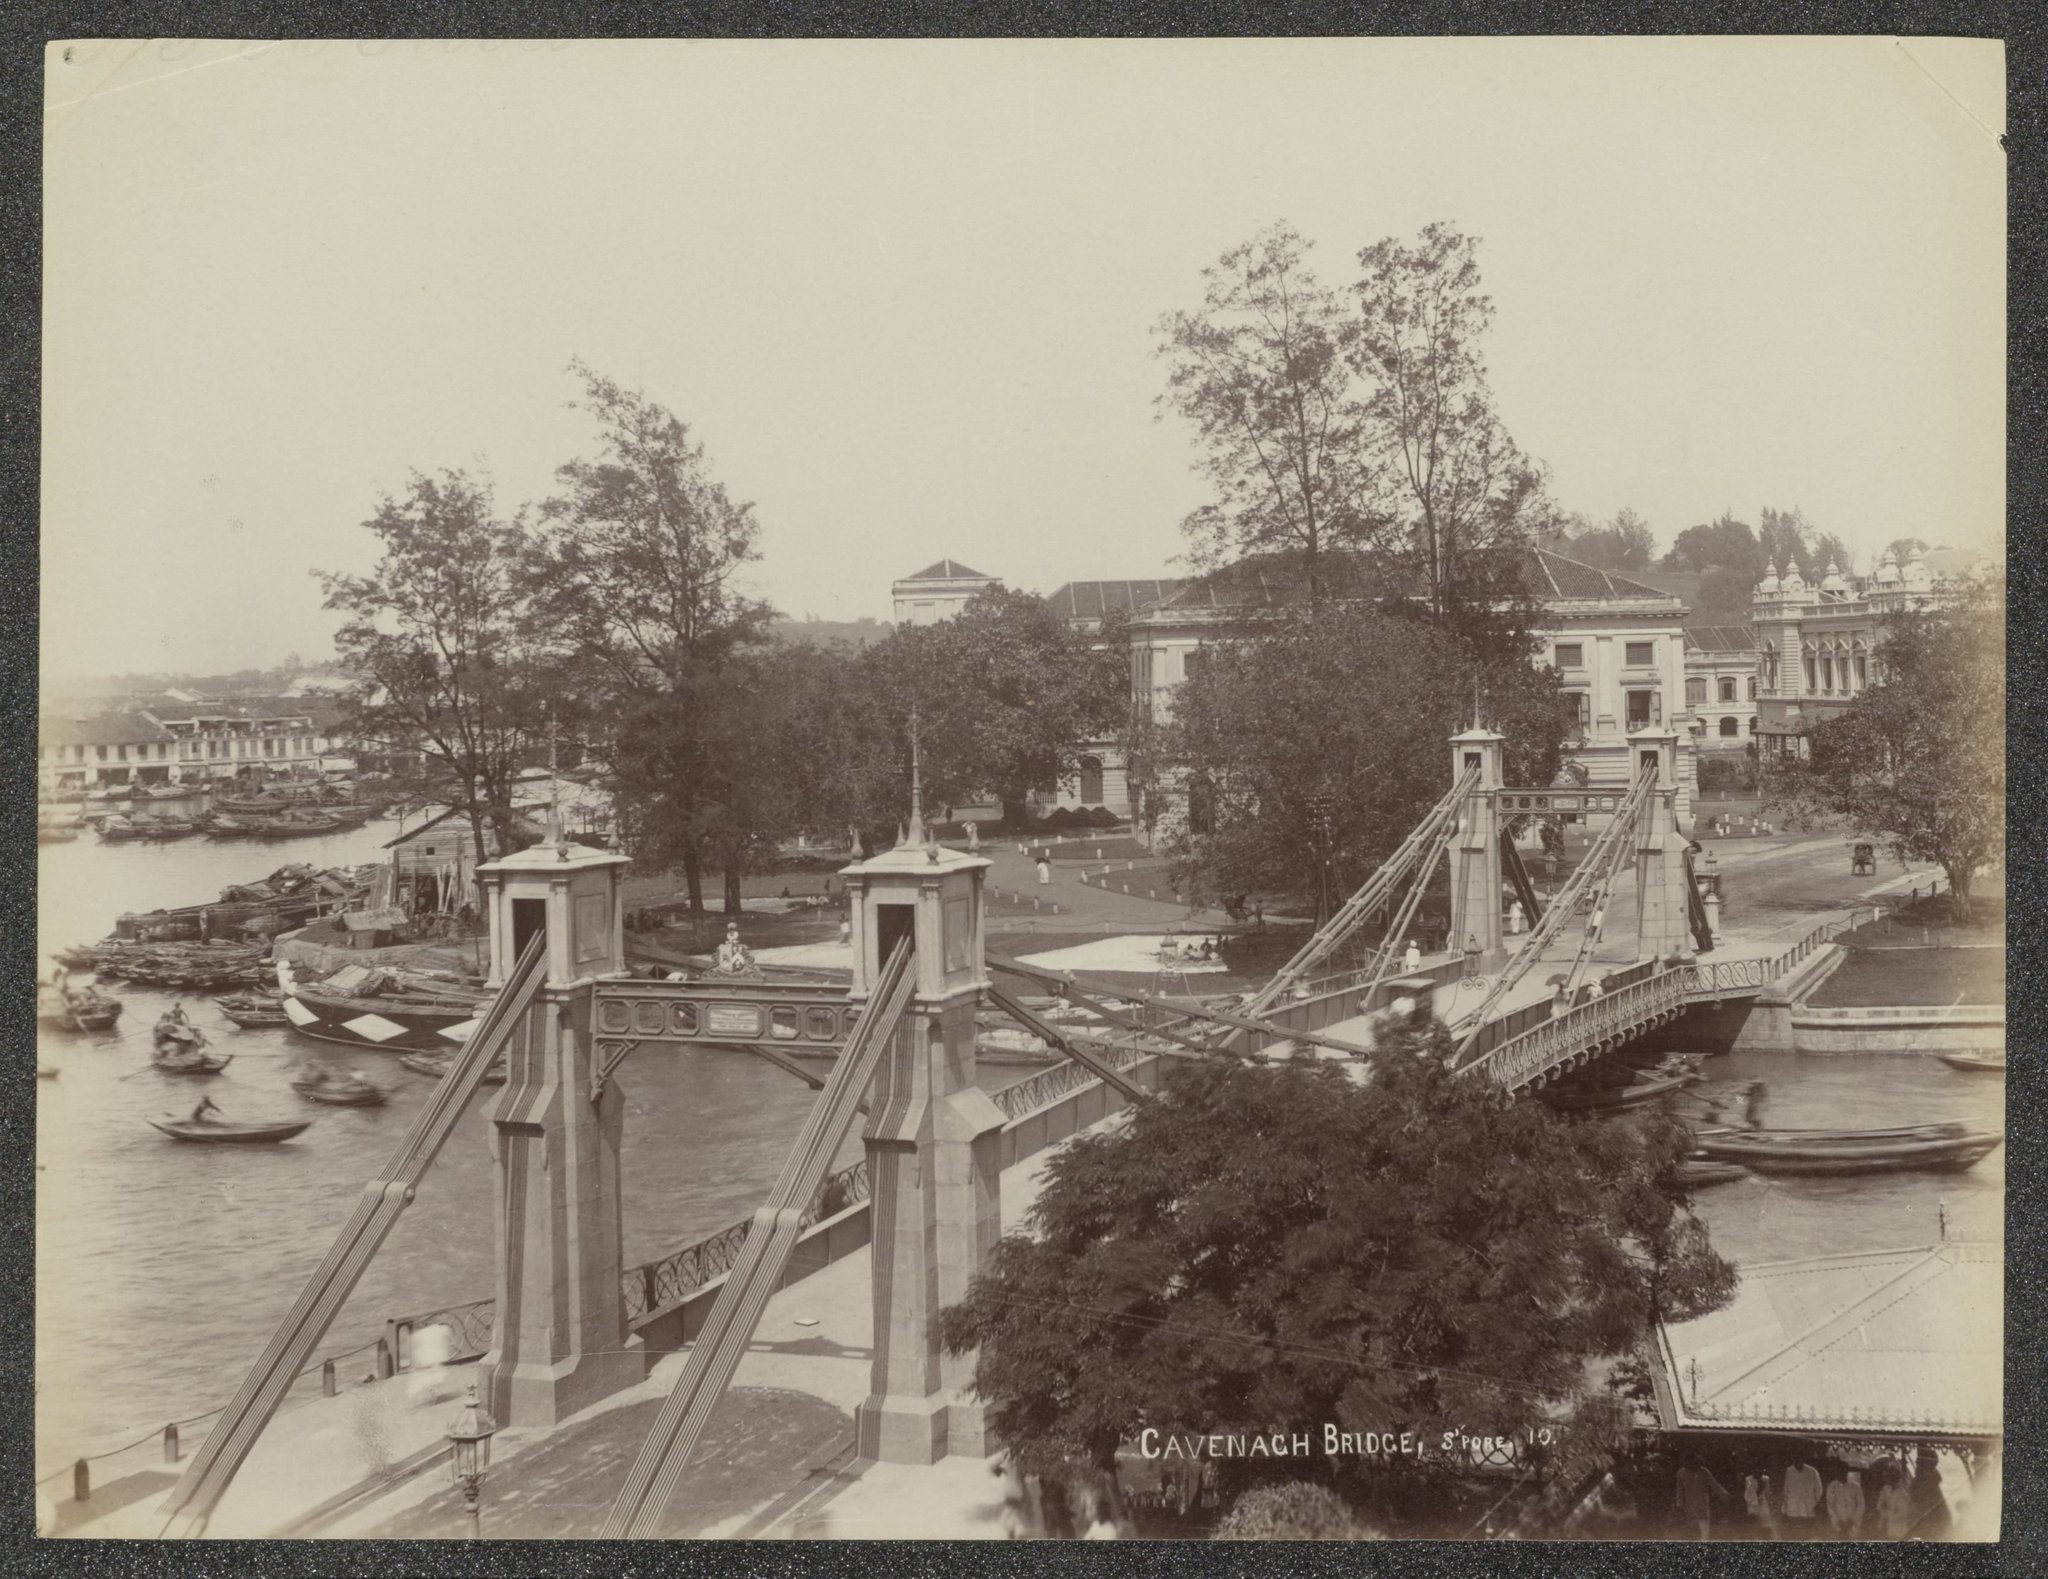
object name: photograph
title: Cavenach Bridge, S'pore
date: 1870-1900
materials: paper, photographic support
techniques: albumen print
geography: singapore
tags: bridge in city across river, canal, etc., singapore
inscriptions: negative number: ‘10’, check stamp: ‘G.R. Lambert Singapore’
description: Onderdeel van Album met 50 foto's van een reis door Zuidoost-Azië.